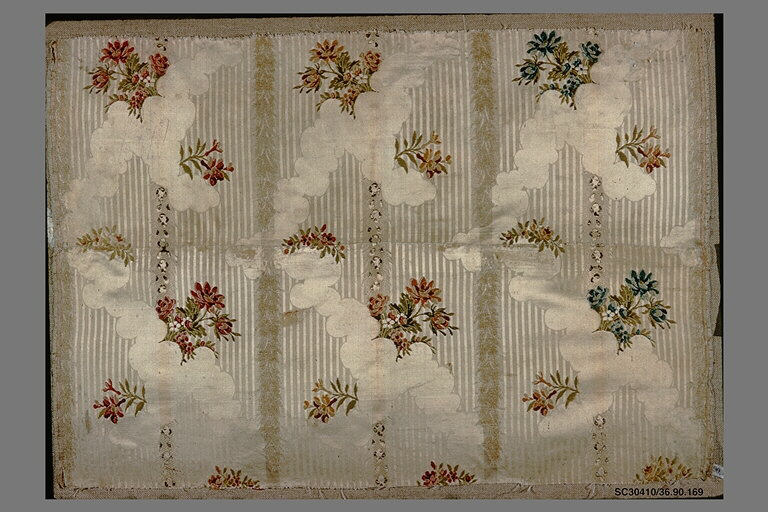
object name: piece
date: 1770-1785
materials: silk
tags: flowers,leaves